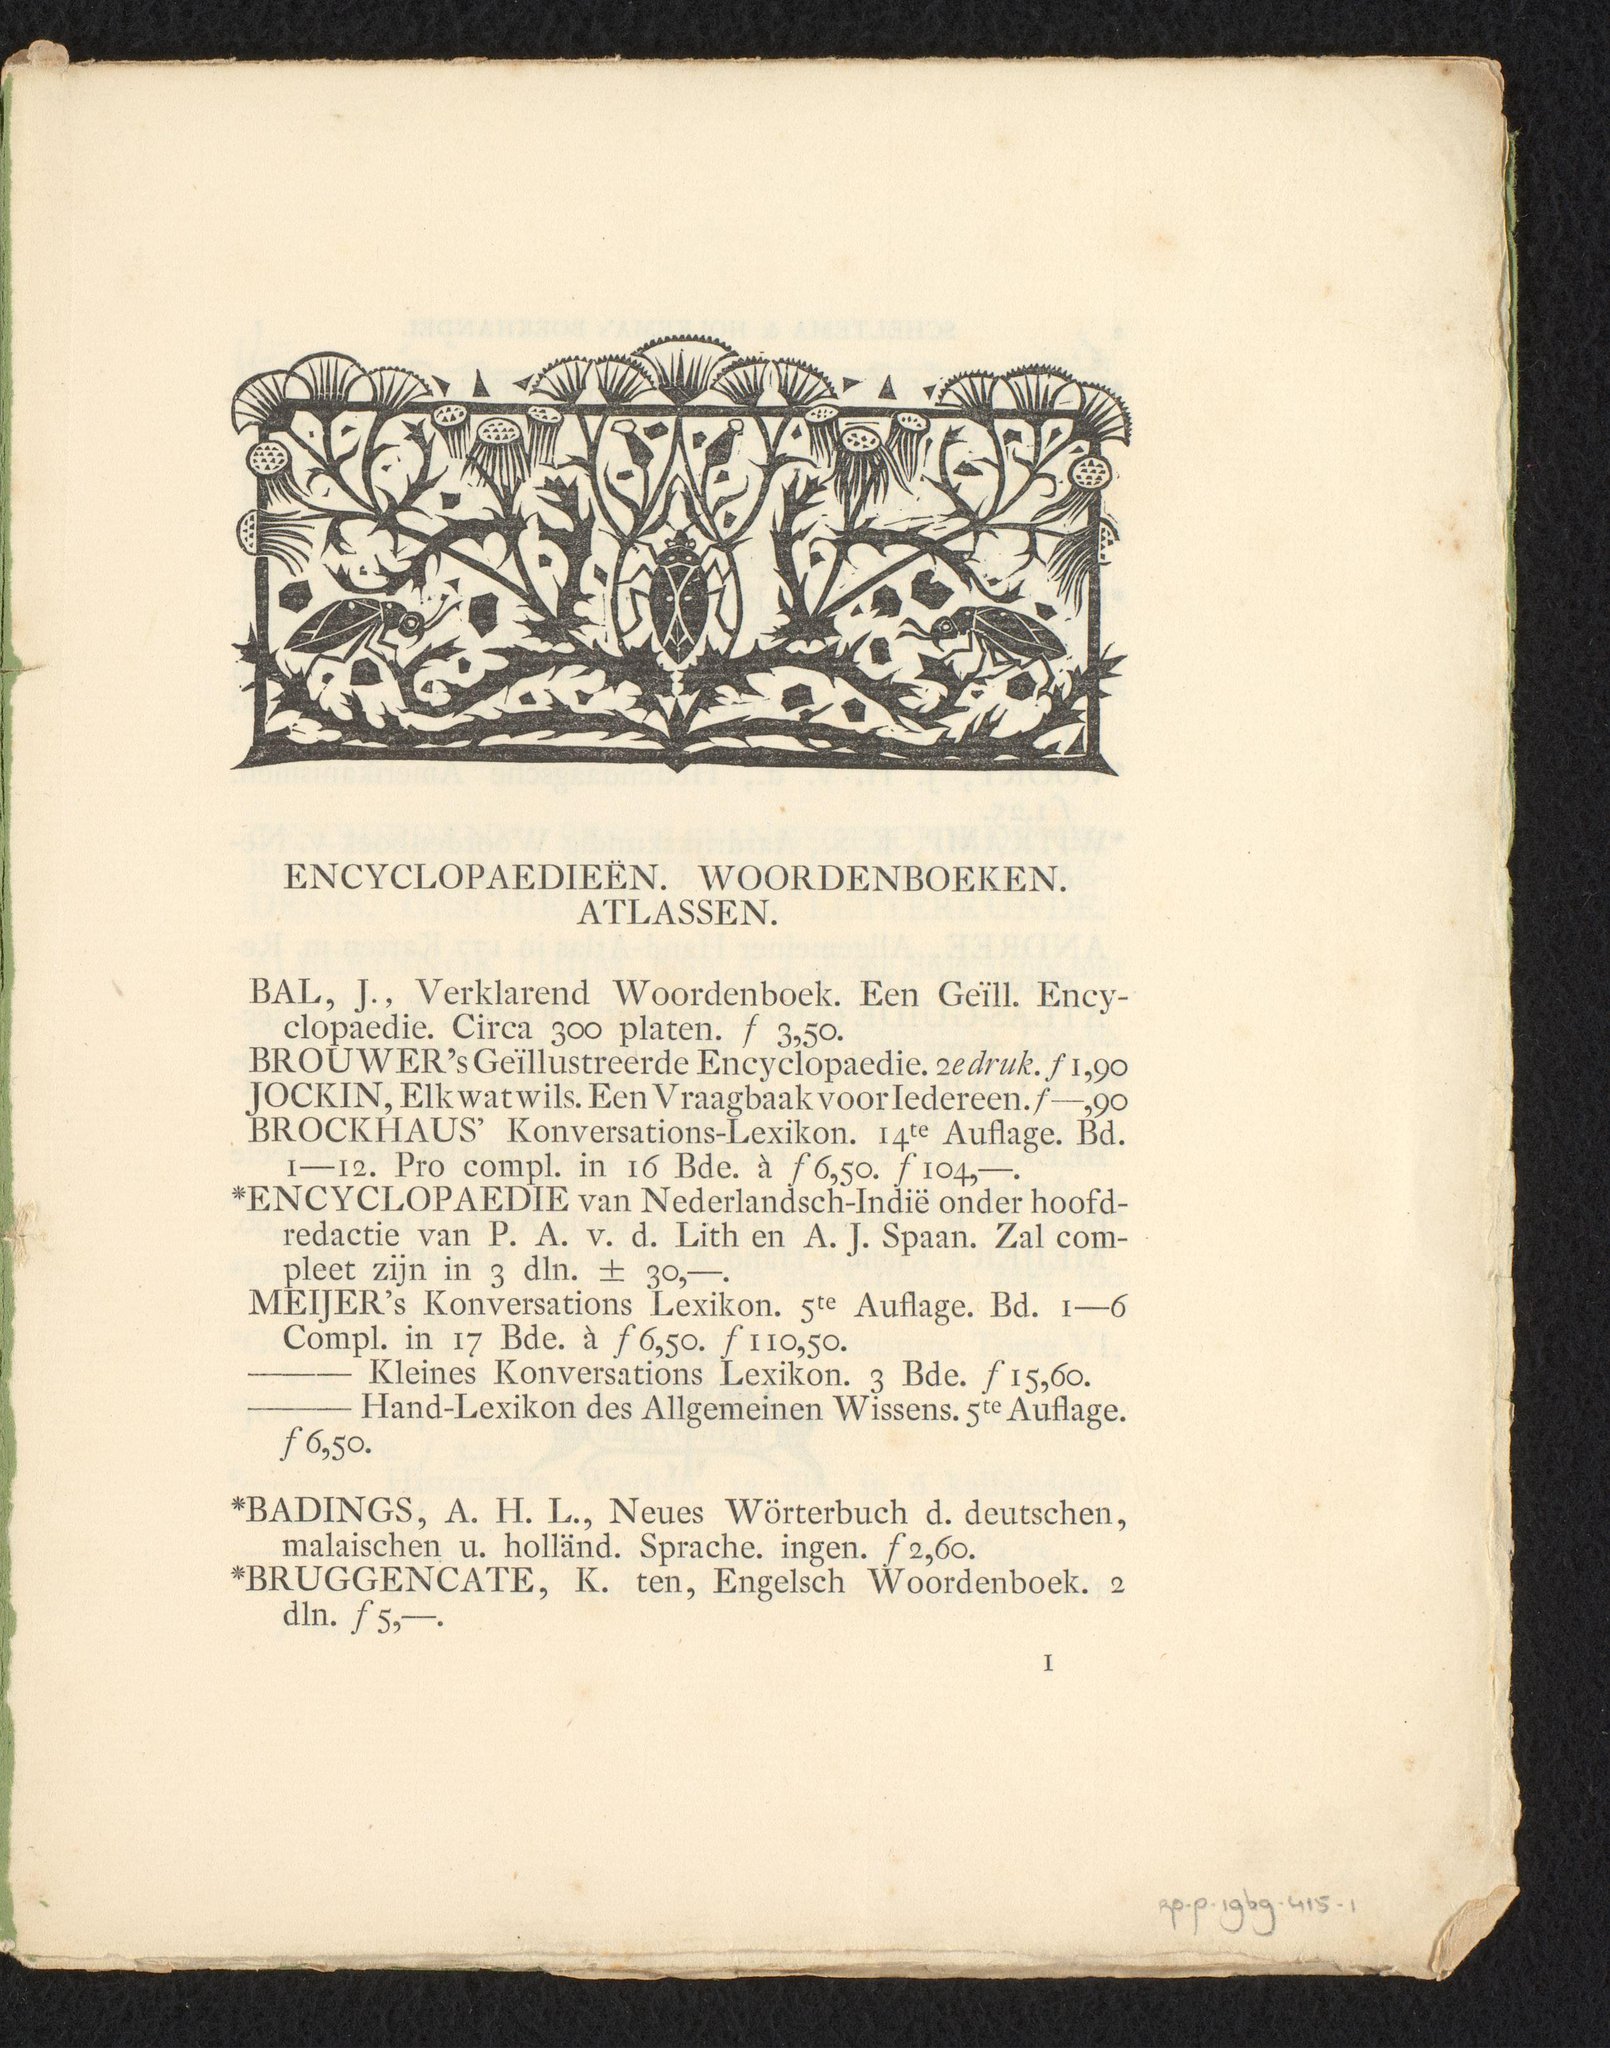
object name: print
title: Titelhoofd met kevers en distels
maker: gerrit willem dijsselhof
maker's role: designer, draughtsman, print maker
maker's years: 1866-1924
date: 1893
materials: paper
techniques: letterpress printing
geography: amsterdam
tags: plants and herbs: thistle, insects: beetle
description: Prent uit: Catalogus van handboeken, pracht- en plaatwerken, dicht- en prozabundels en kinderliteratuur (...). Amsterdam: Scheltema & Holkema's Boekhandel, 1894, p. 1. Deze prent werd origineel ontworpen ter illustratie van: Crane, Walter. Kunst en samenleving. [Vertaald uit het Engels door] Jan Veth. Amsterdam: Scheltema & Holkema's Boekhandel, 1894 [1893], p. 102.